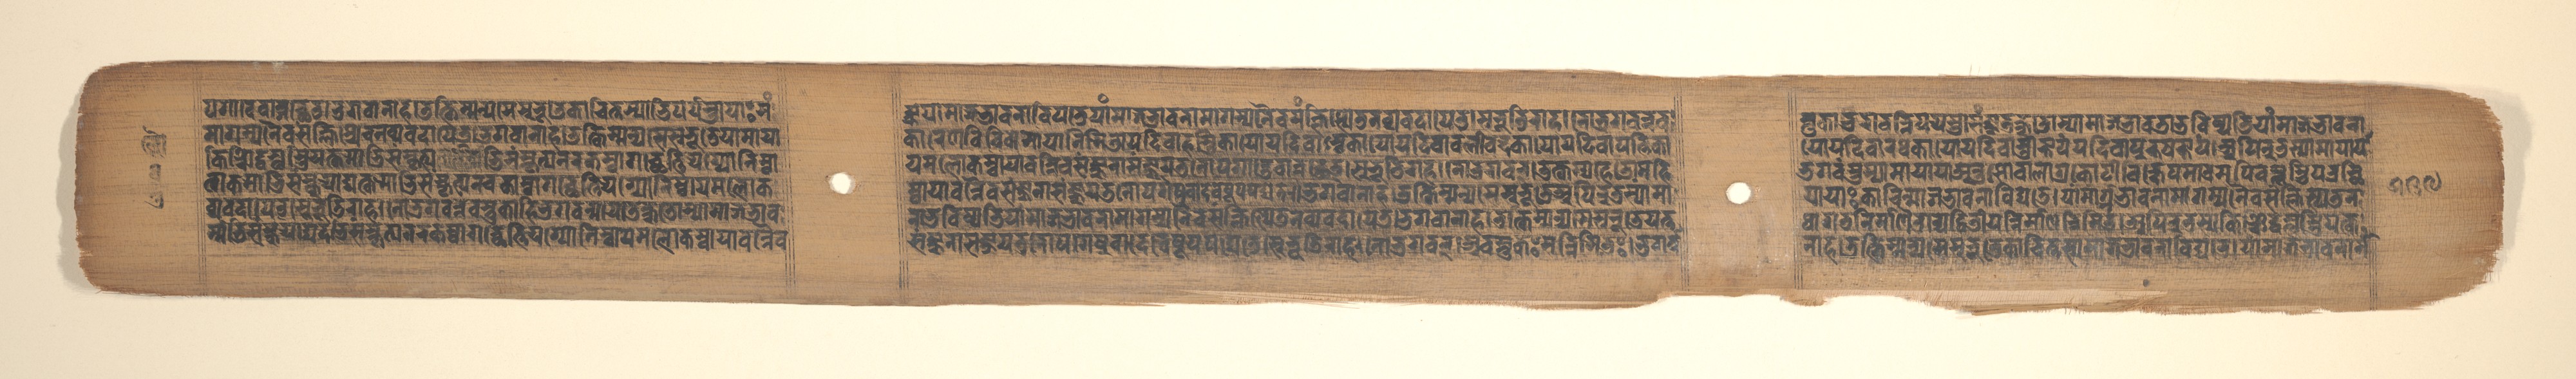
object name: folio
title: Folio from a Buddhist Manuscript of Pancavimsatisahasrika Prajnaparamita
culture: indian, bengal or bangladesh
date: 1090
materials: leaf, watercolor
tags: buddhism